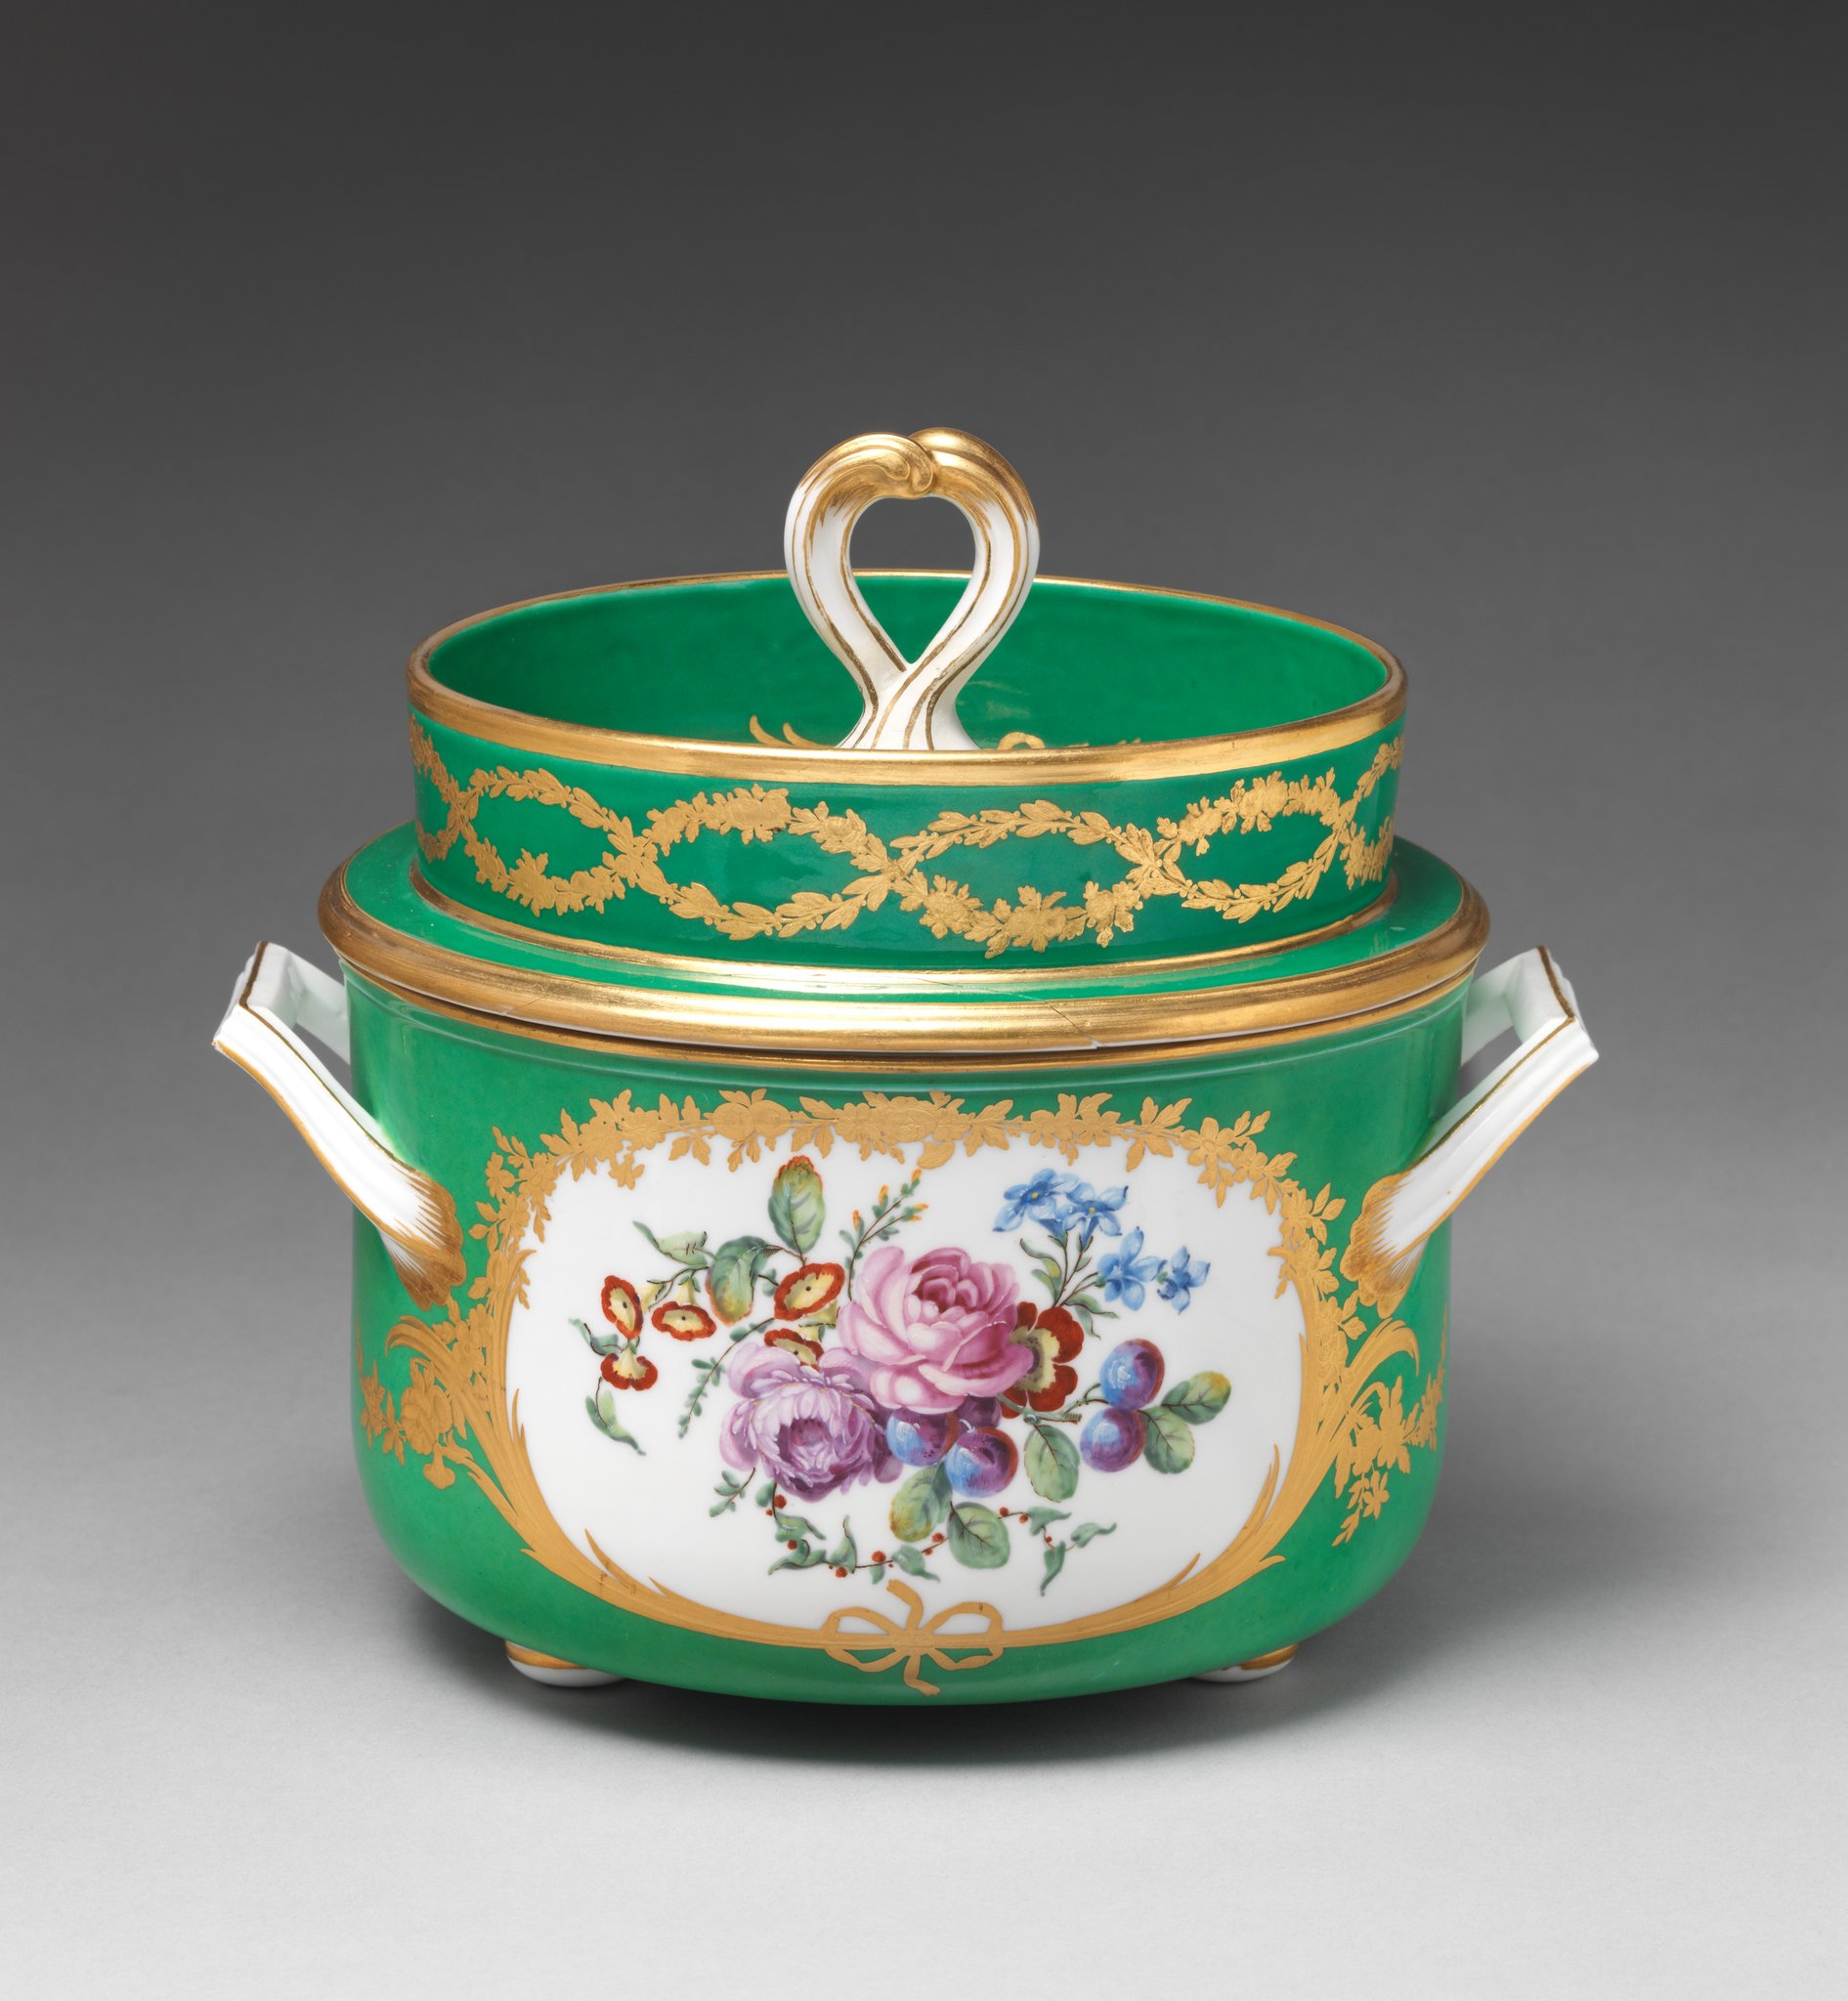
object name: ice pail with cover and liner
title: Ice pail with cover (Seau à glace) (part of a service)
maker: sèvres manufactory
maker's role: manufactory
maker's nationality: french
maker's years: 1740-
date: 1770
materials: soft paste porcelain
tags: flowers